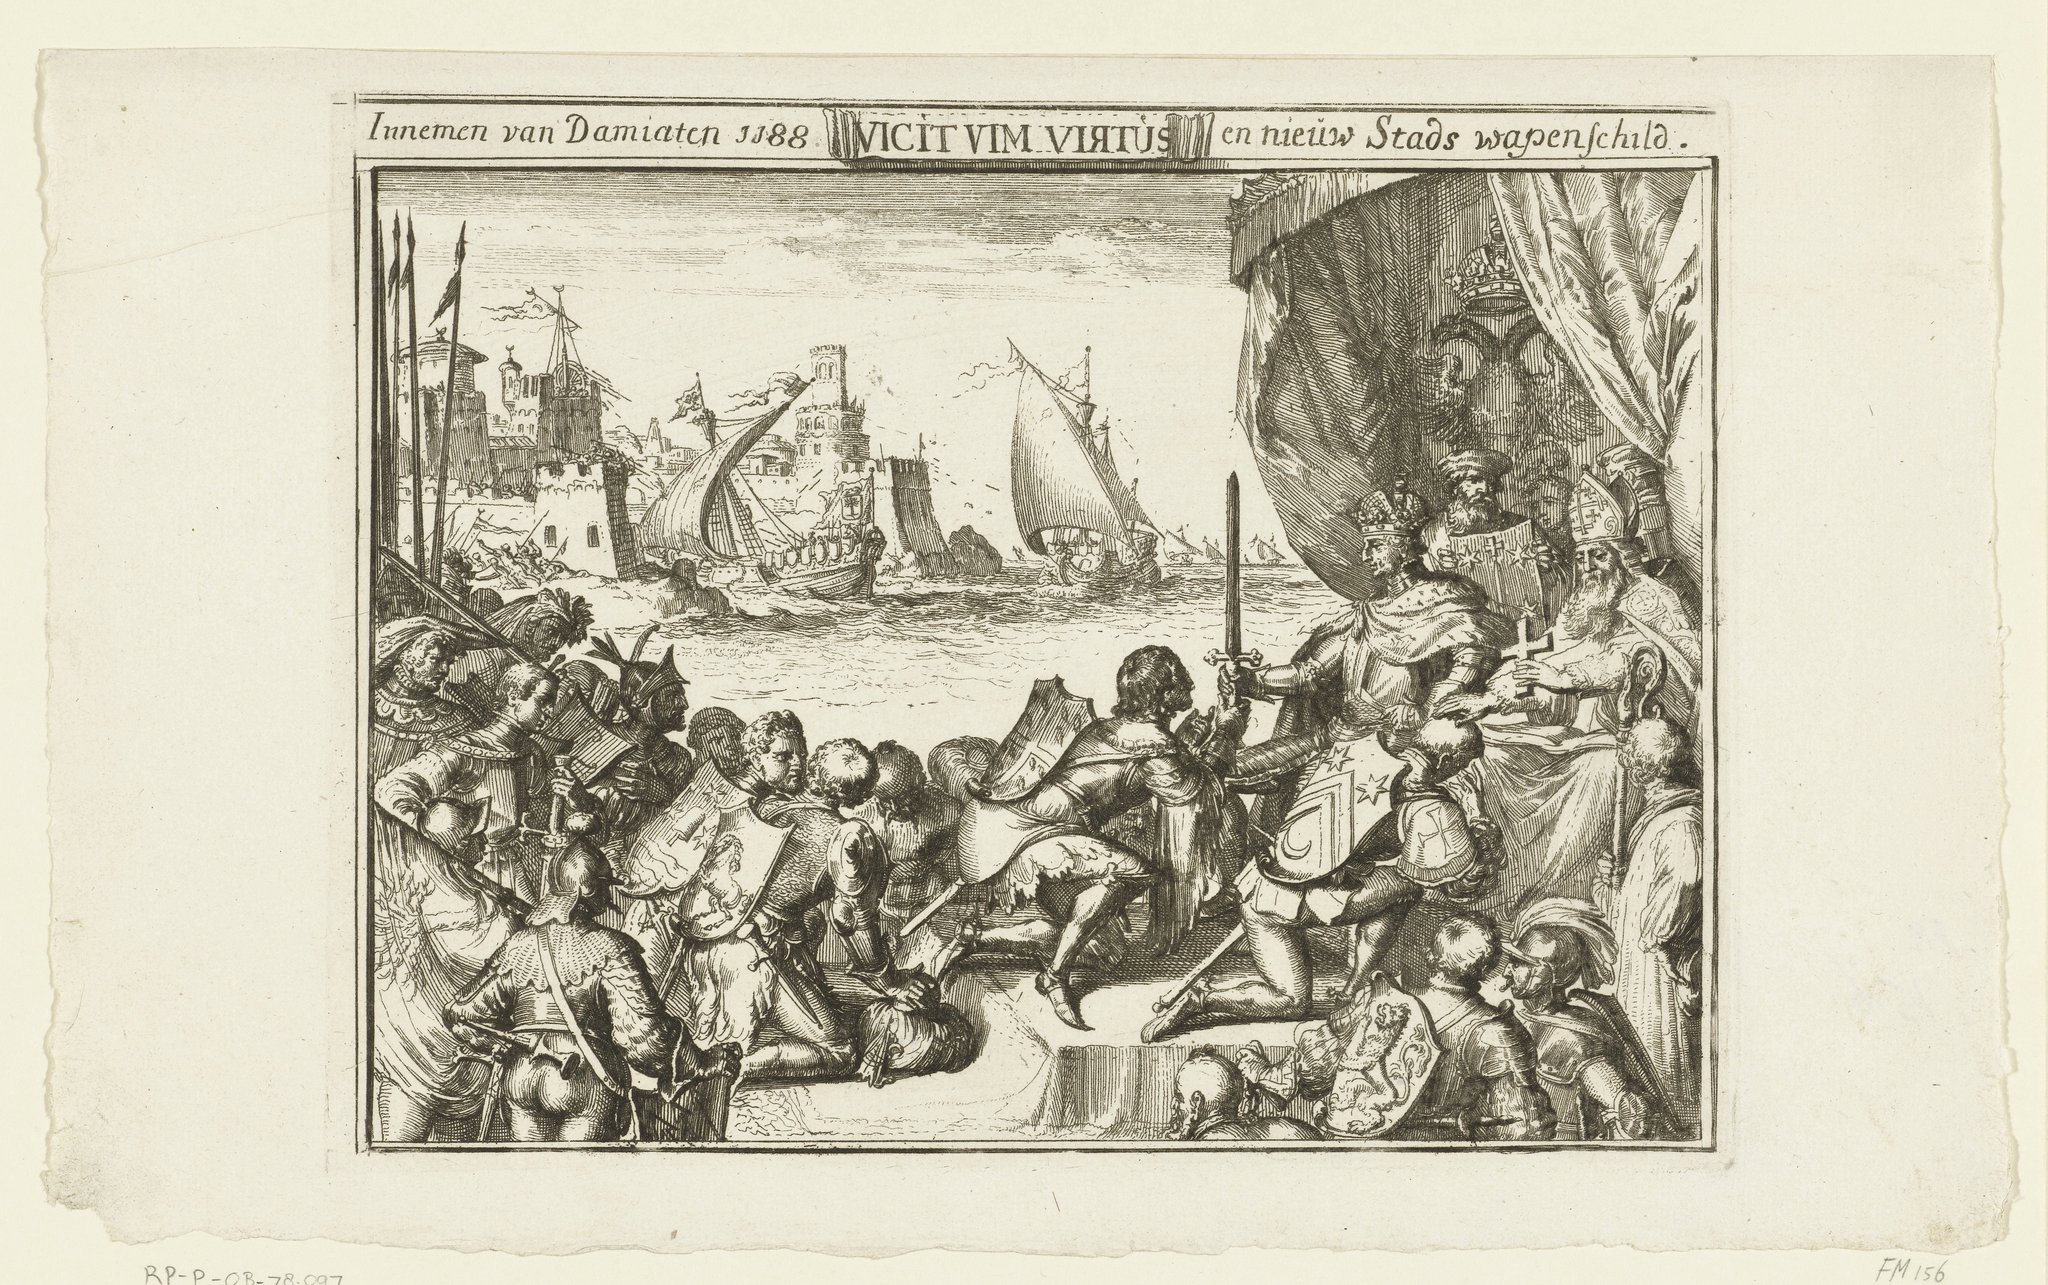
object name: print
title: Innemen van Damiaten 1188 en nieuw stads wapenschild / Vicit vim virtus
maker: romeyn de hooghe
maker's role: draughtsman, goldsmith, painter, print maker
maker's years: 1645-1708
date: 1688-1689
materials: paper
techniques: etching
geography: northern netherlands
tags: haarlem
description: Kruisridders geknield voor de keizer en de paus ontvangen van deze de zegen en een zwaard. Op de achtergrond de verovering van de stad Damiate met het doorvaren van de ketting van de haven, 1219. Dit blad maakt deel uit van een omvangrijke prent met een grote plattegrond van Haarlem, omgeven door zeven wapenschilden, een profiel van de stad, gezichten op markante Haarlemse gebouwen en voorstellingen van belangrijke momenten uit de Haarlemse geschiedenis.